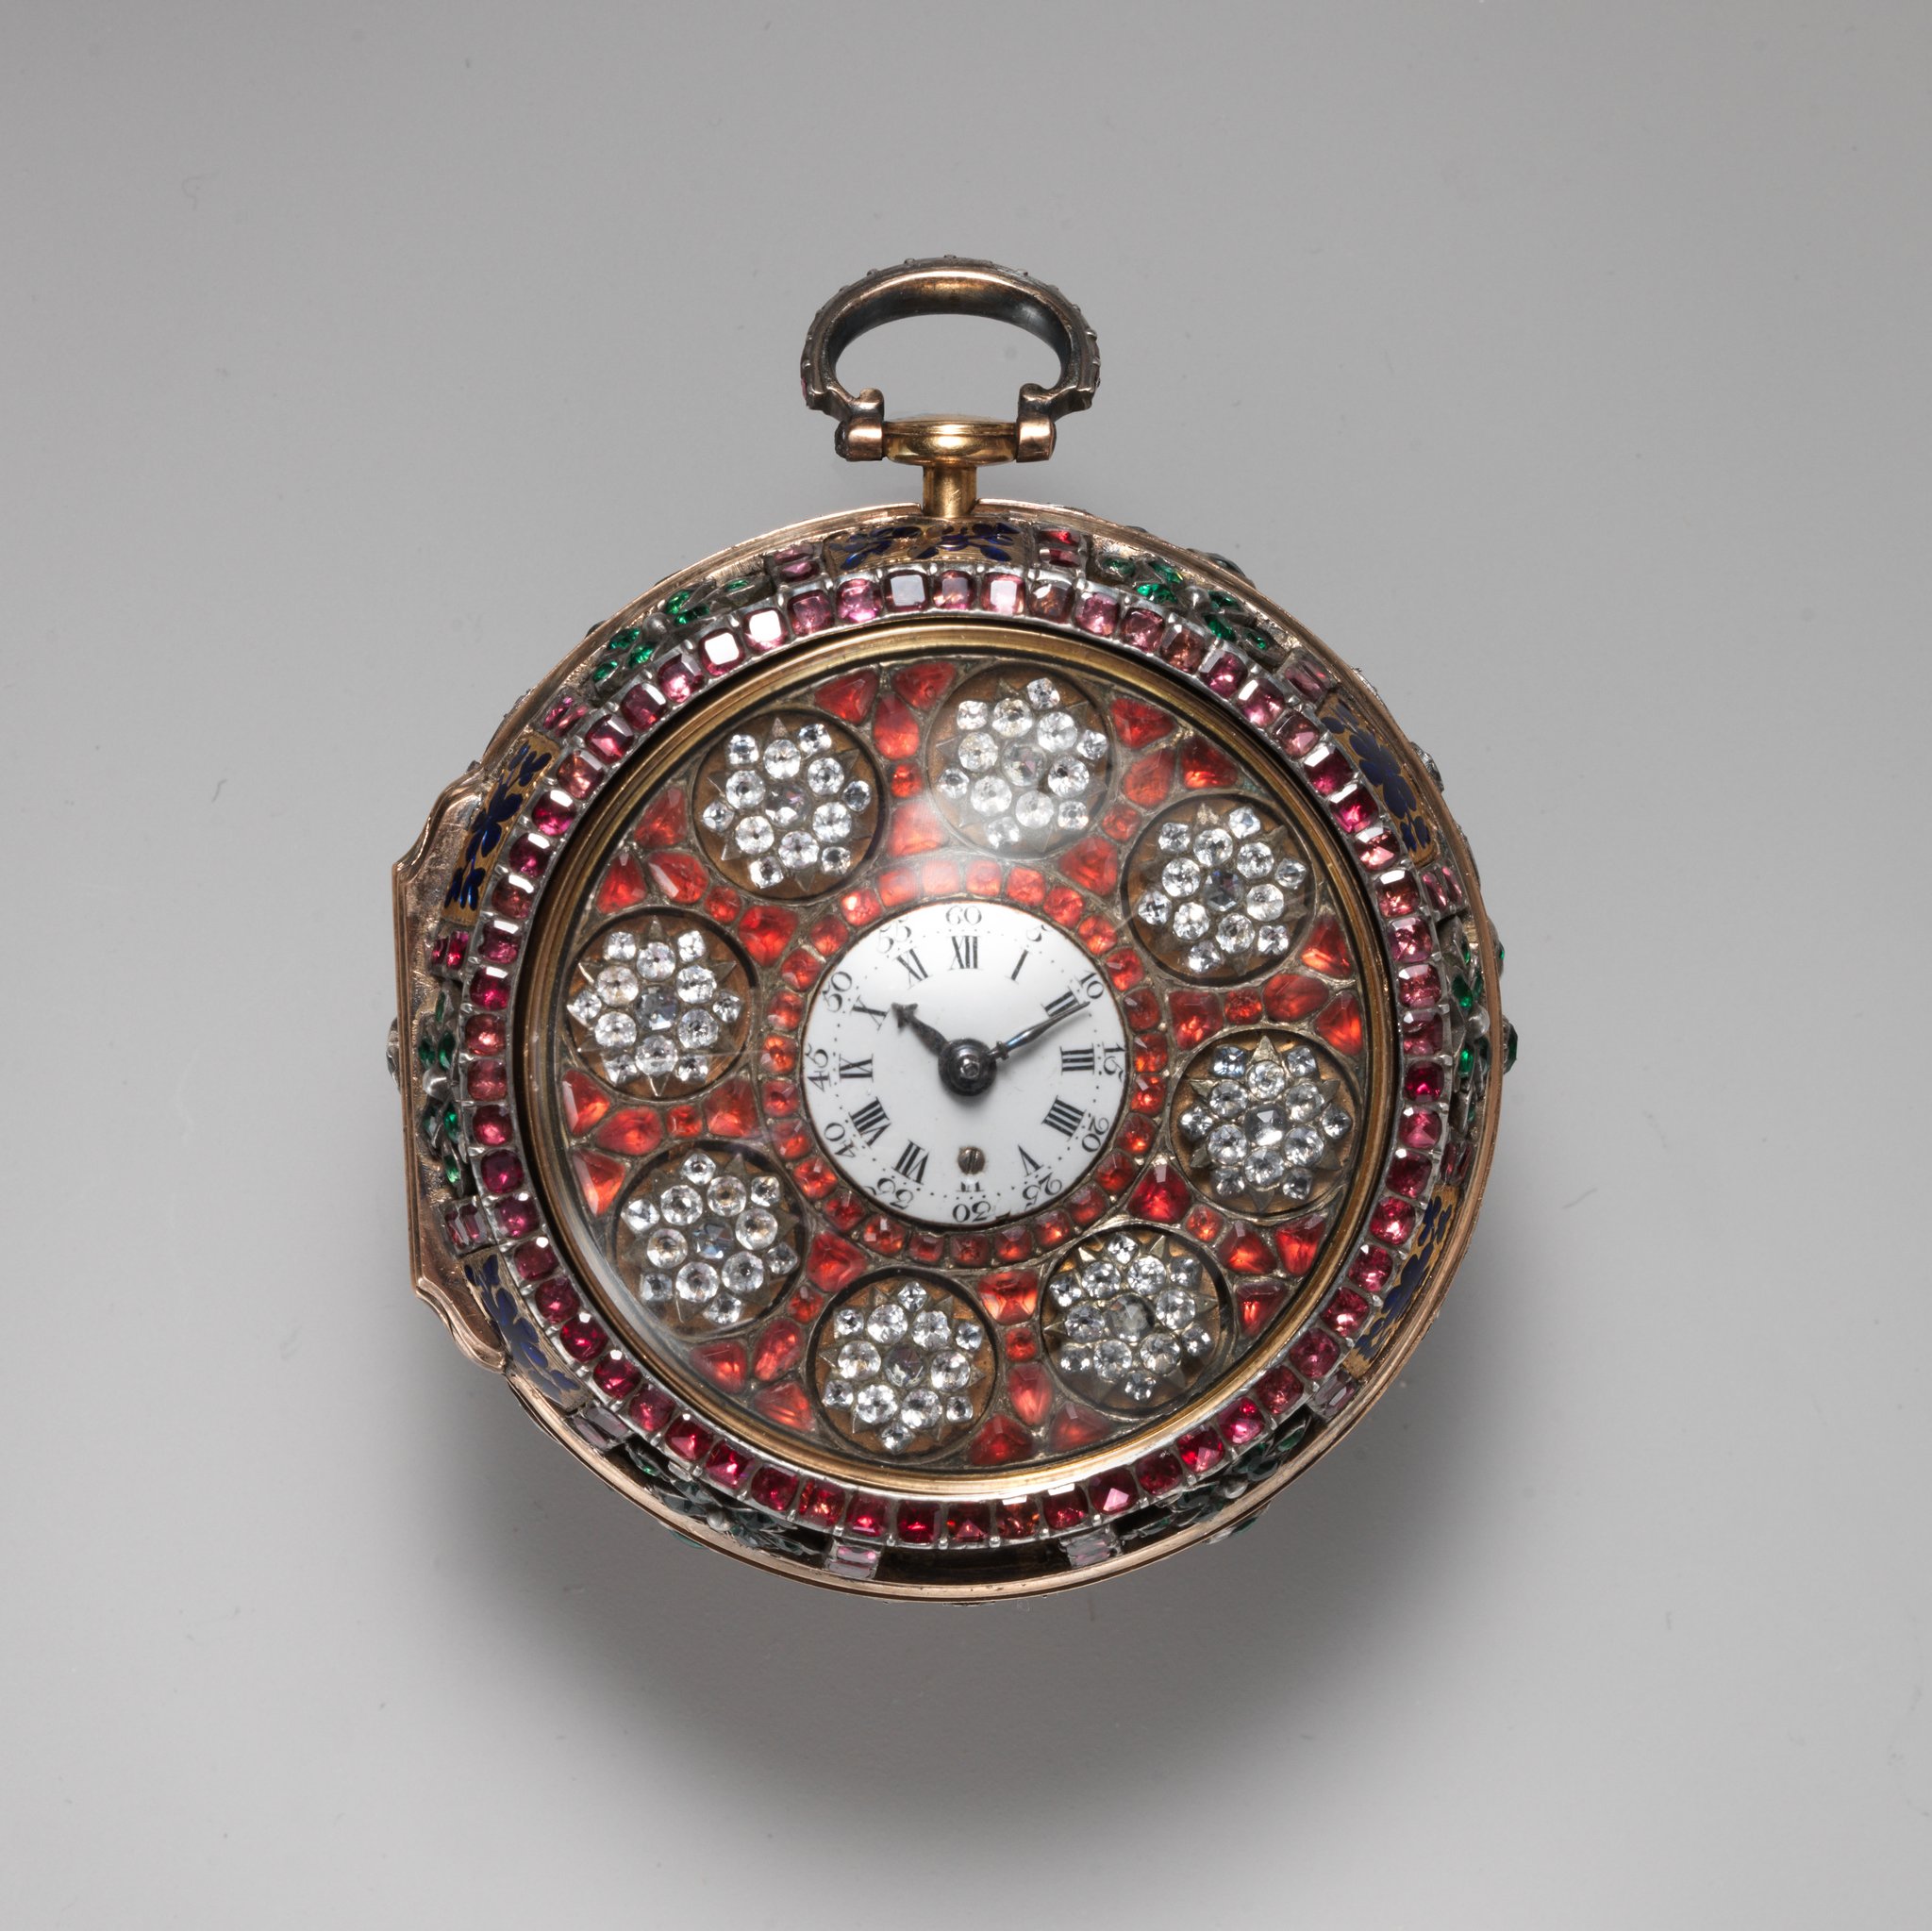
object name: pair case automaton watch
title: Pair-case automaton watch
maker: james cox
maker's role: entrepreneur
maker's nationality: british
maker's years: 1723-1800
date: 1770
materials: diamond, enamel, gold, paste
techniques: enamel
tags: peacocks